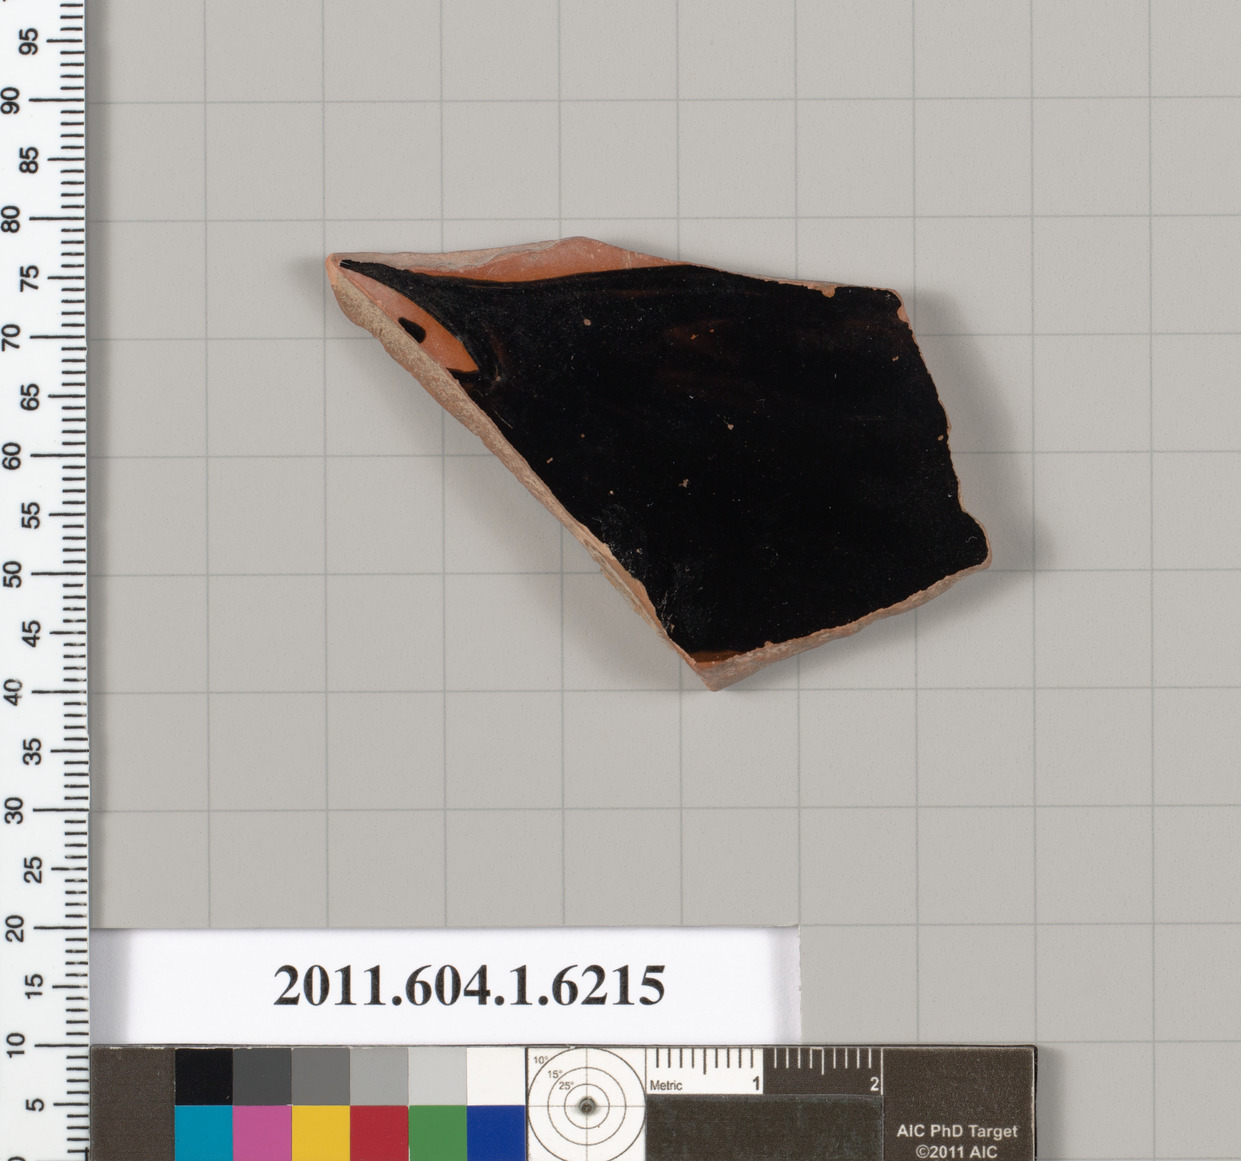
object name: kylix fragment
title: Terracotta fragment of a kylix (drinking cup)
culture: greek, attic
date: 510-500 BCE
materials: terracotta